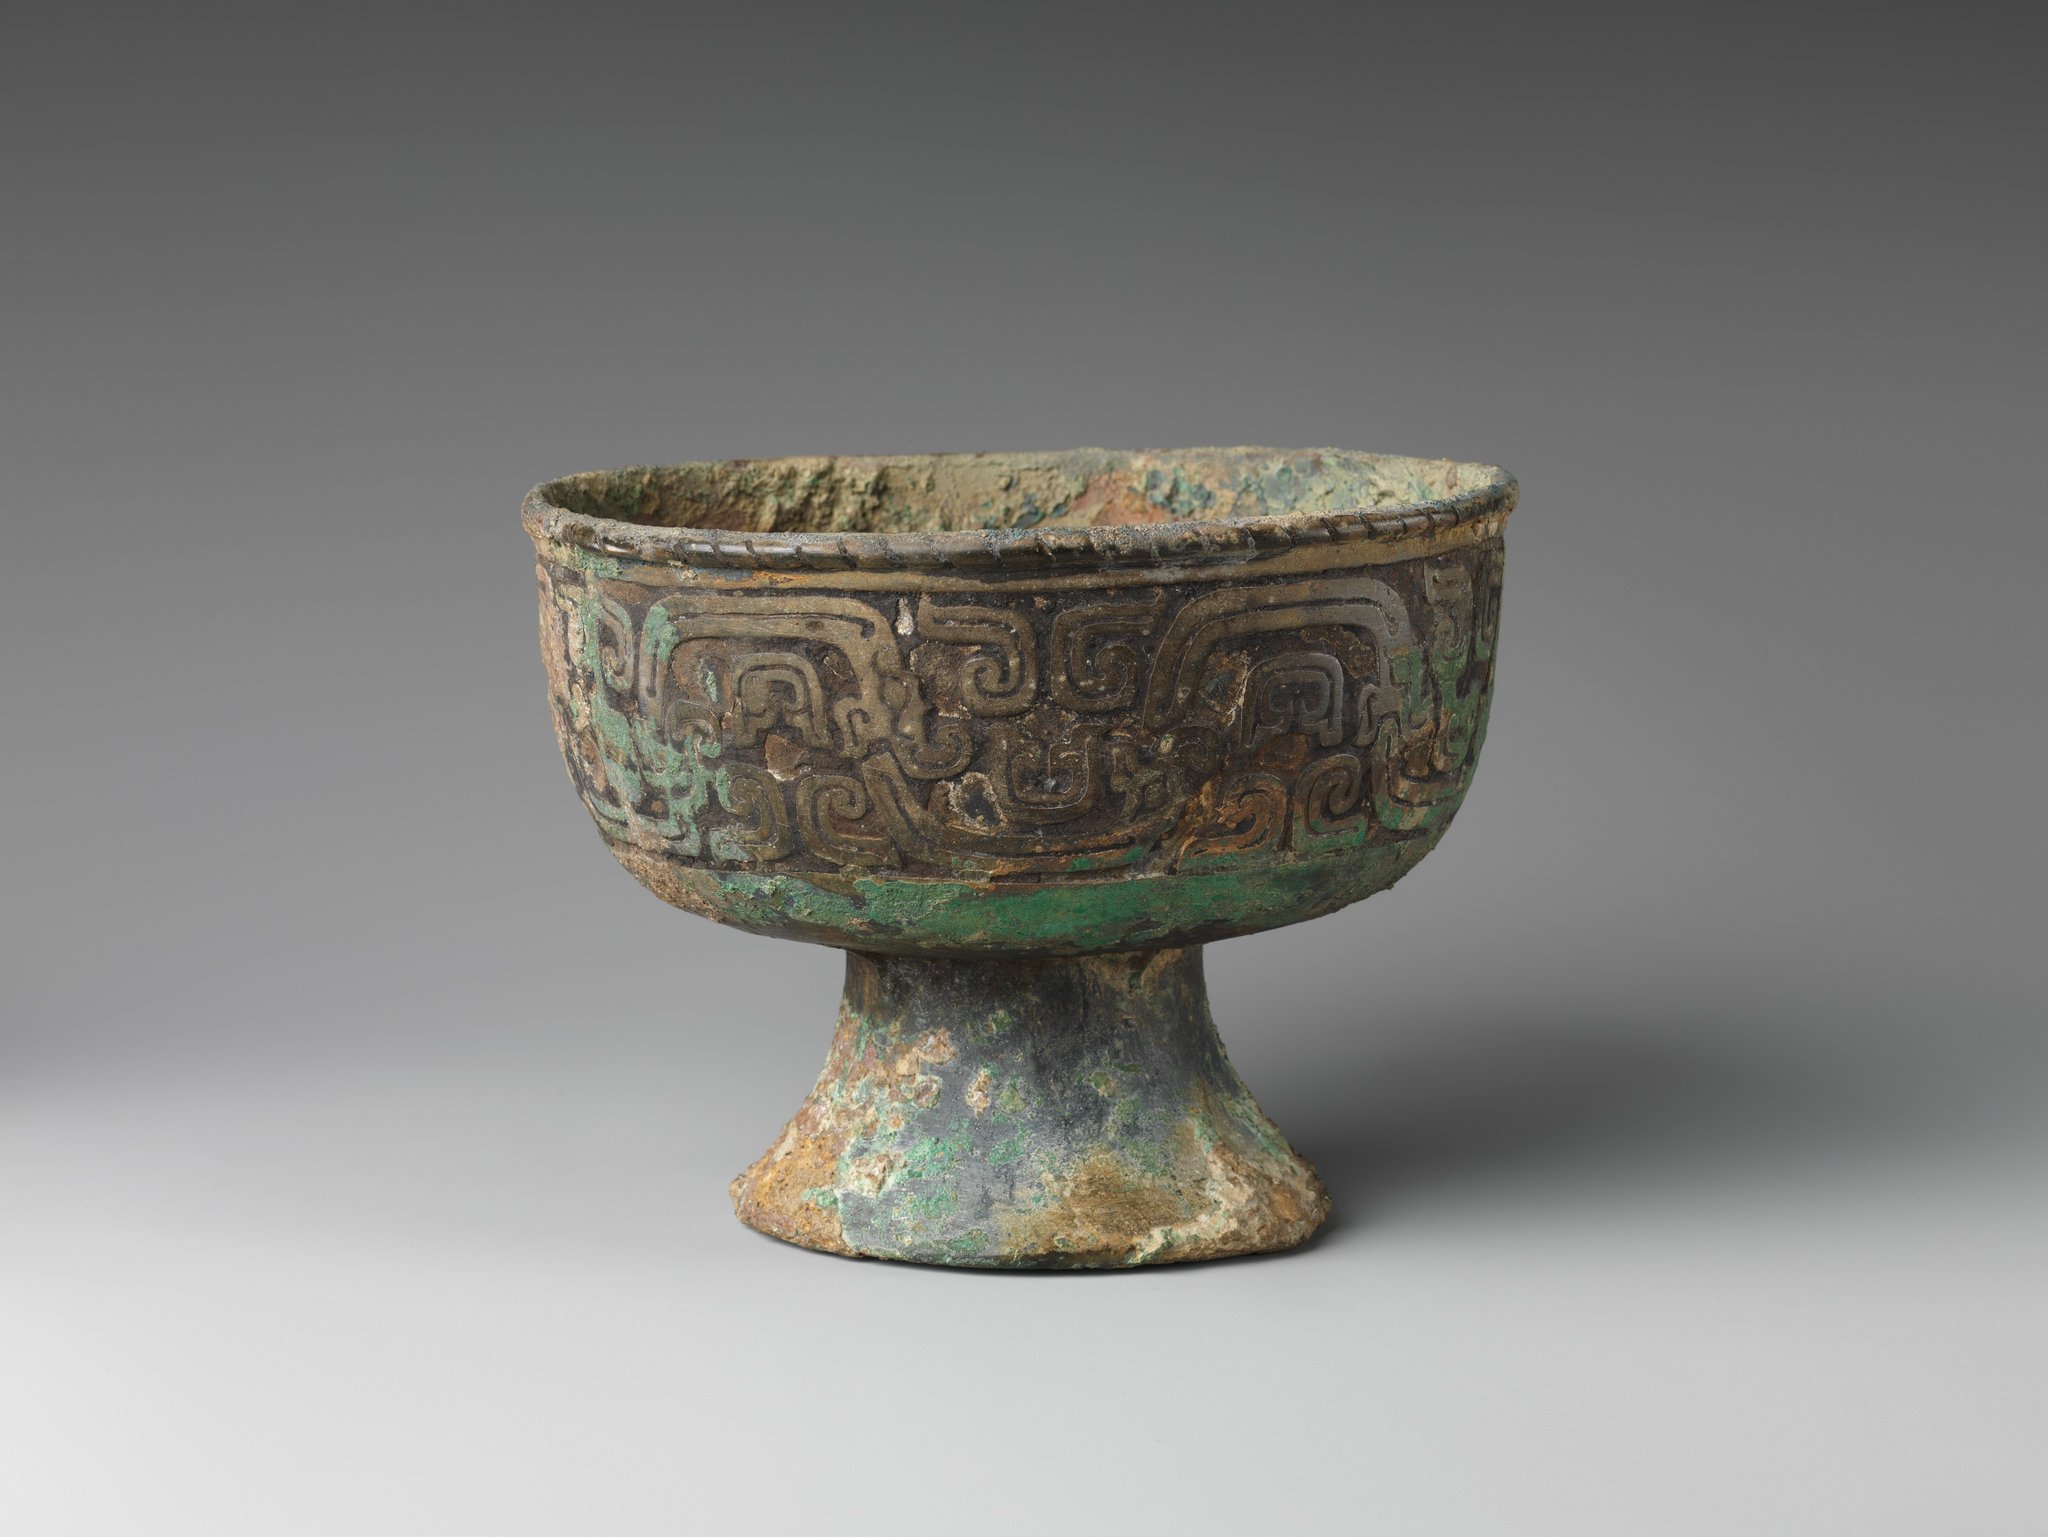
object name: bowl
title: Stemmed Bowl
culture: chinese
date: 800-701 BCE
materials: bronze